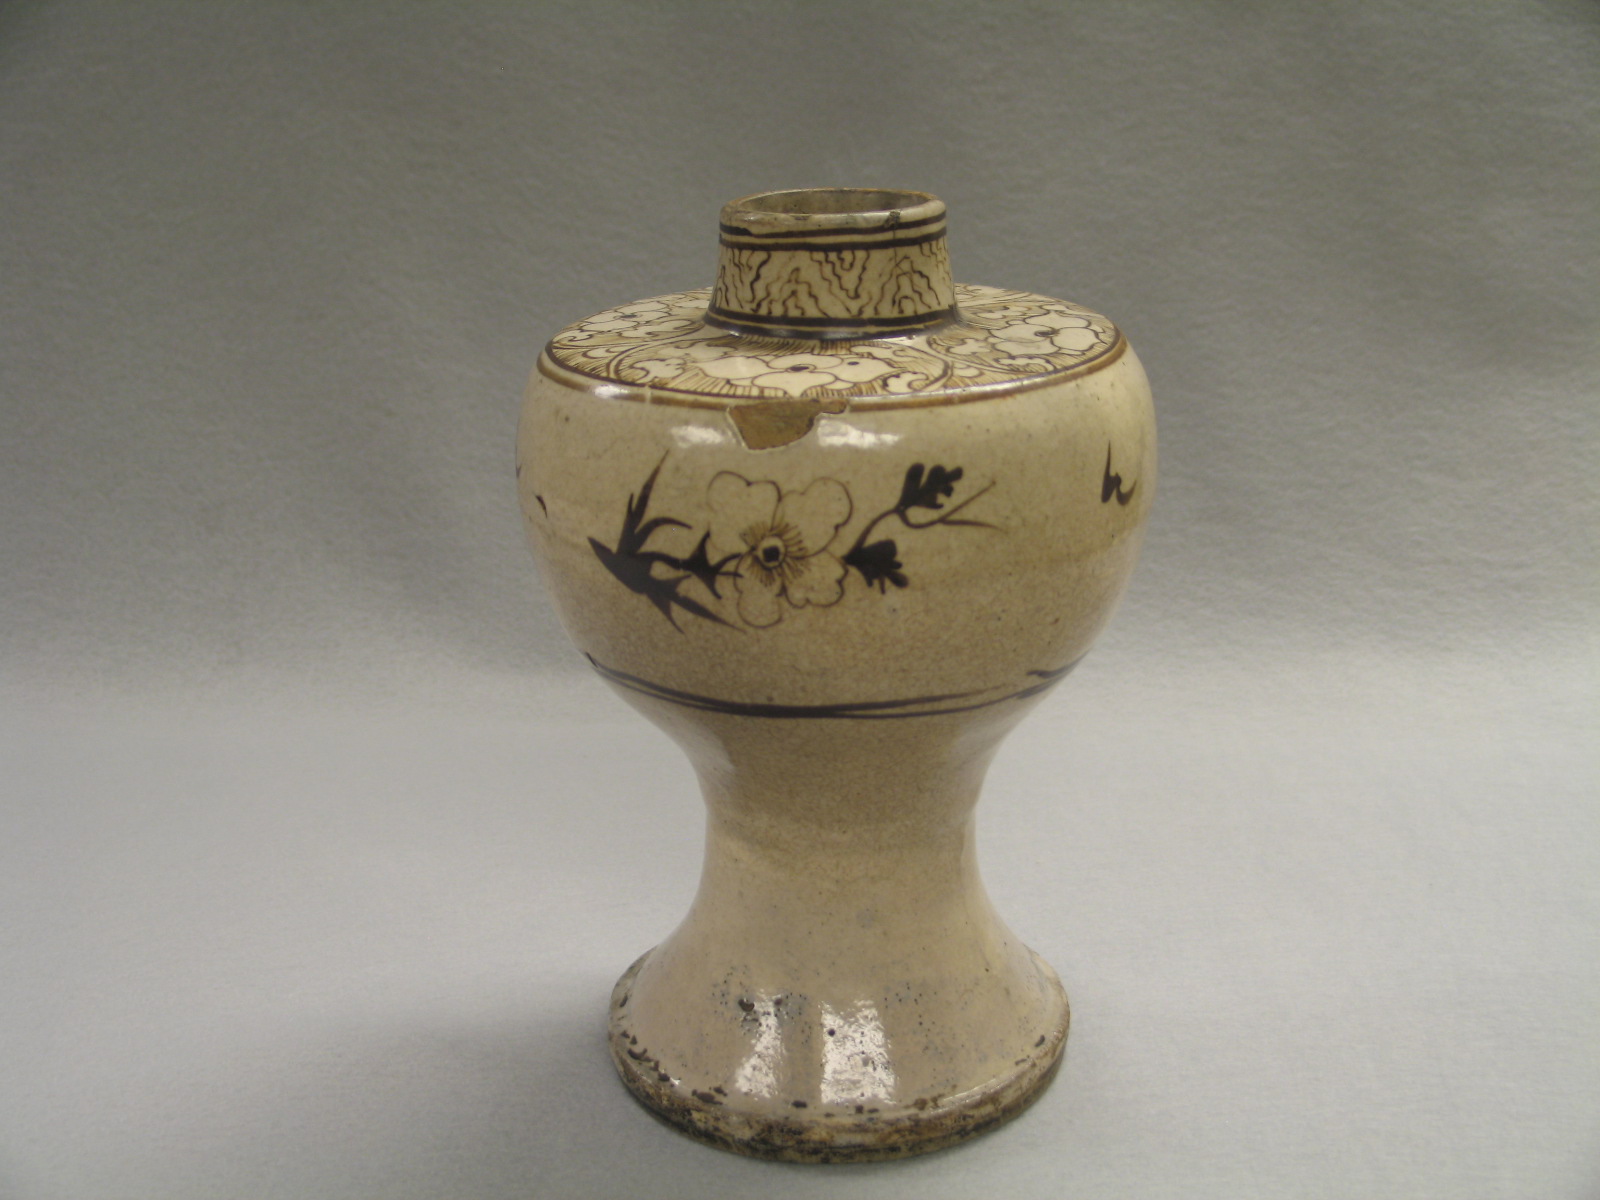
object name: vase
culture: chinese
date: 1501-1700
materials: iron, pigment, stoneware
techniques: painting